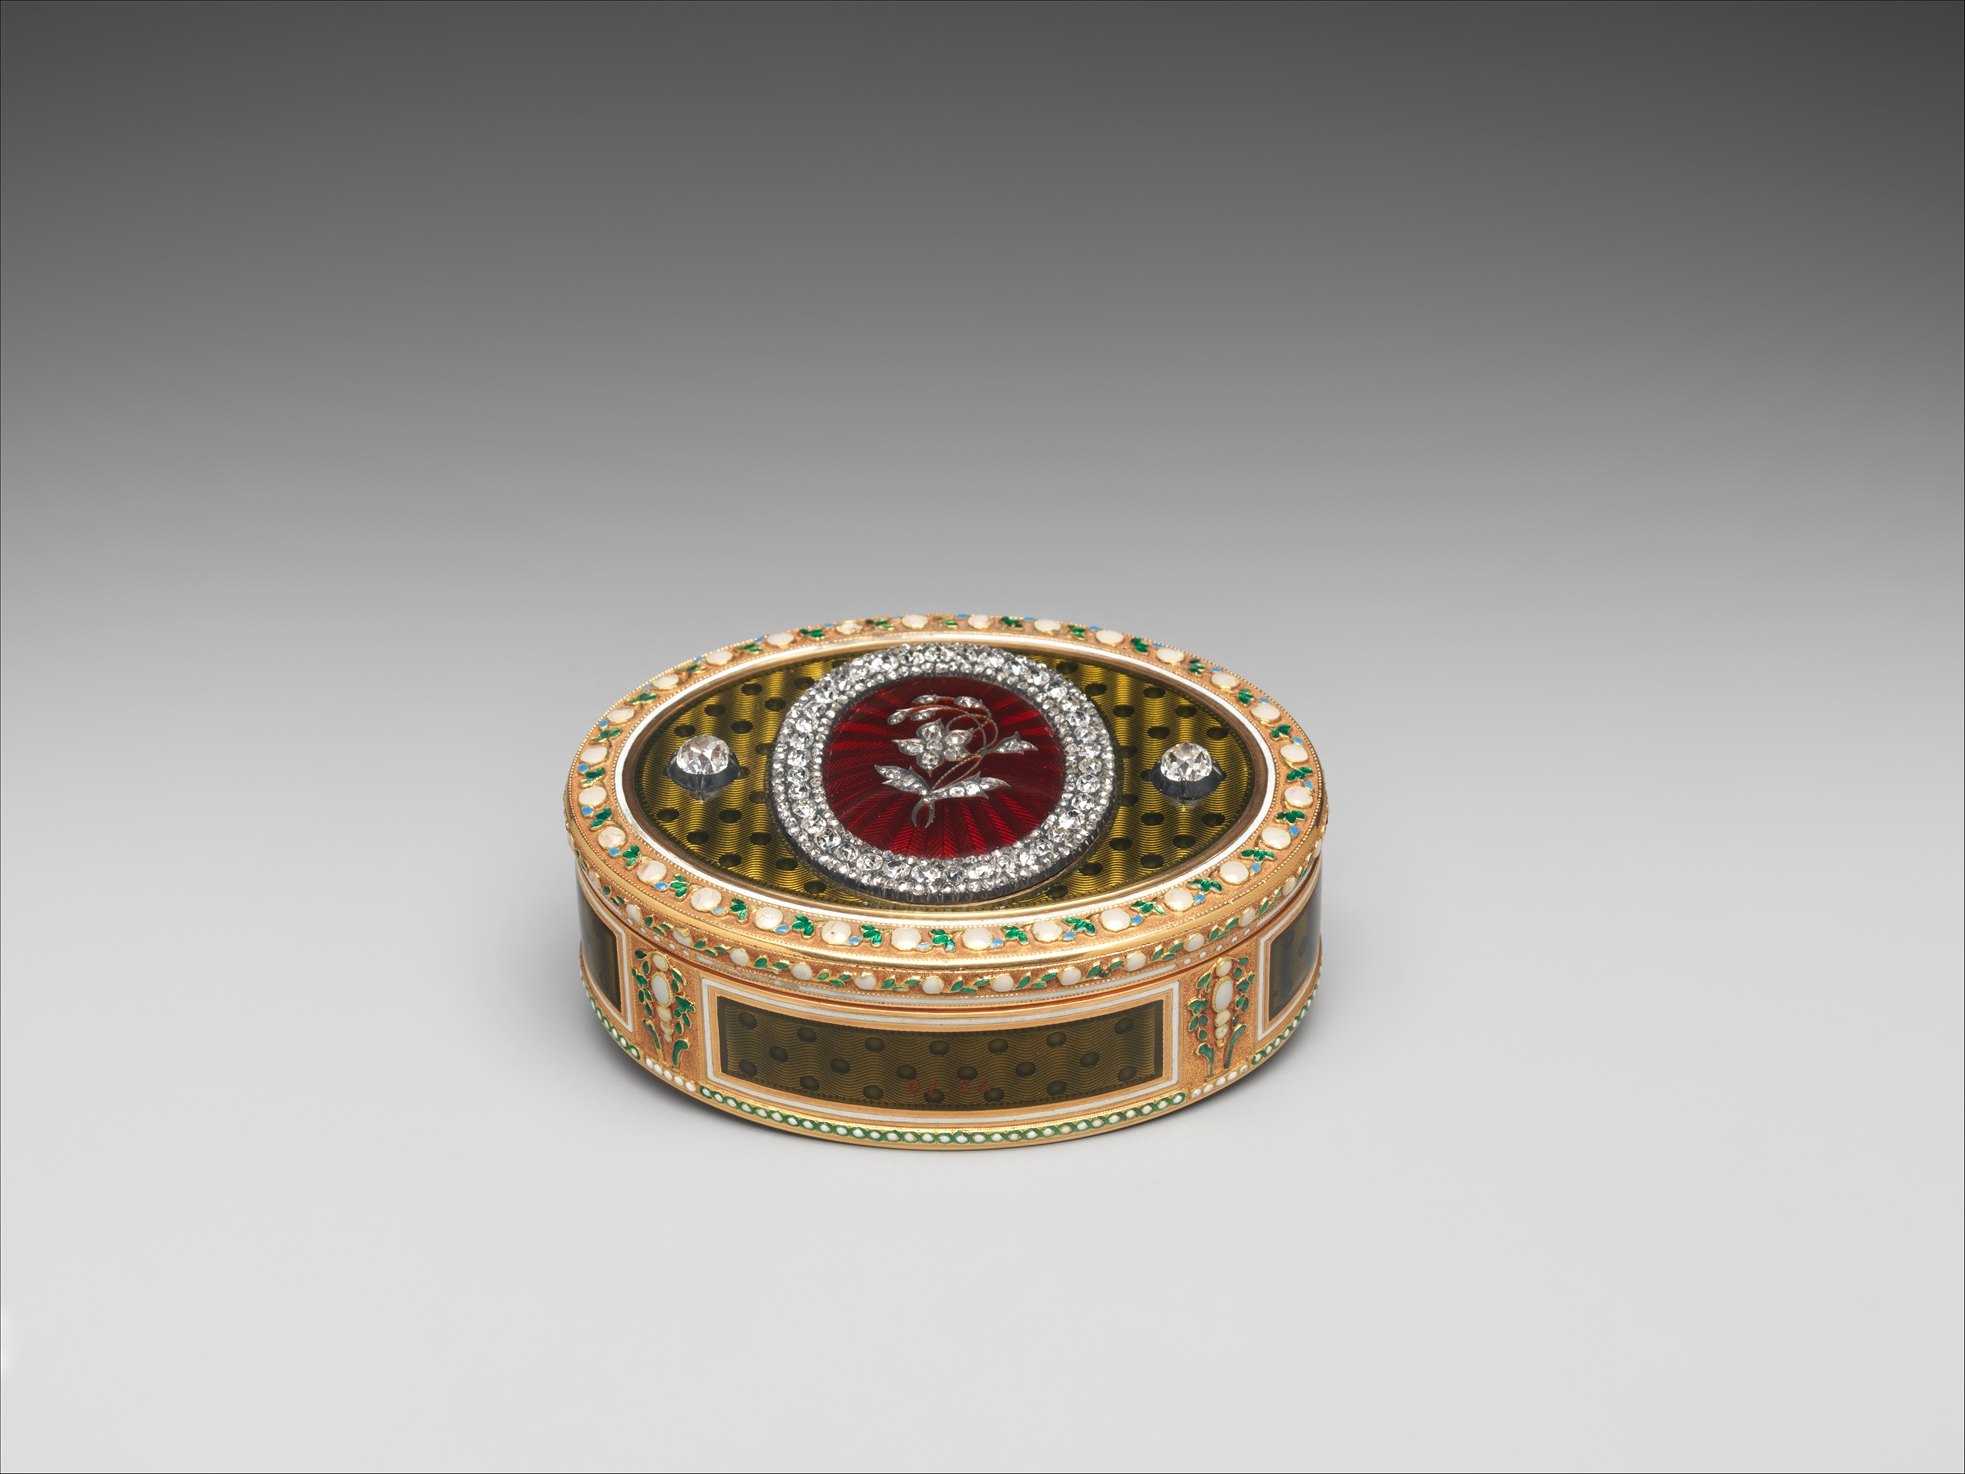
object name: snuffbox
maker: l.f.t., switzerland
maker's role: maker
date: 1801-1833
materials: diamond, enamel, gold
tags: flowers